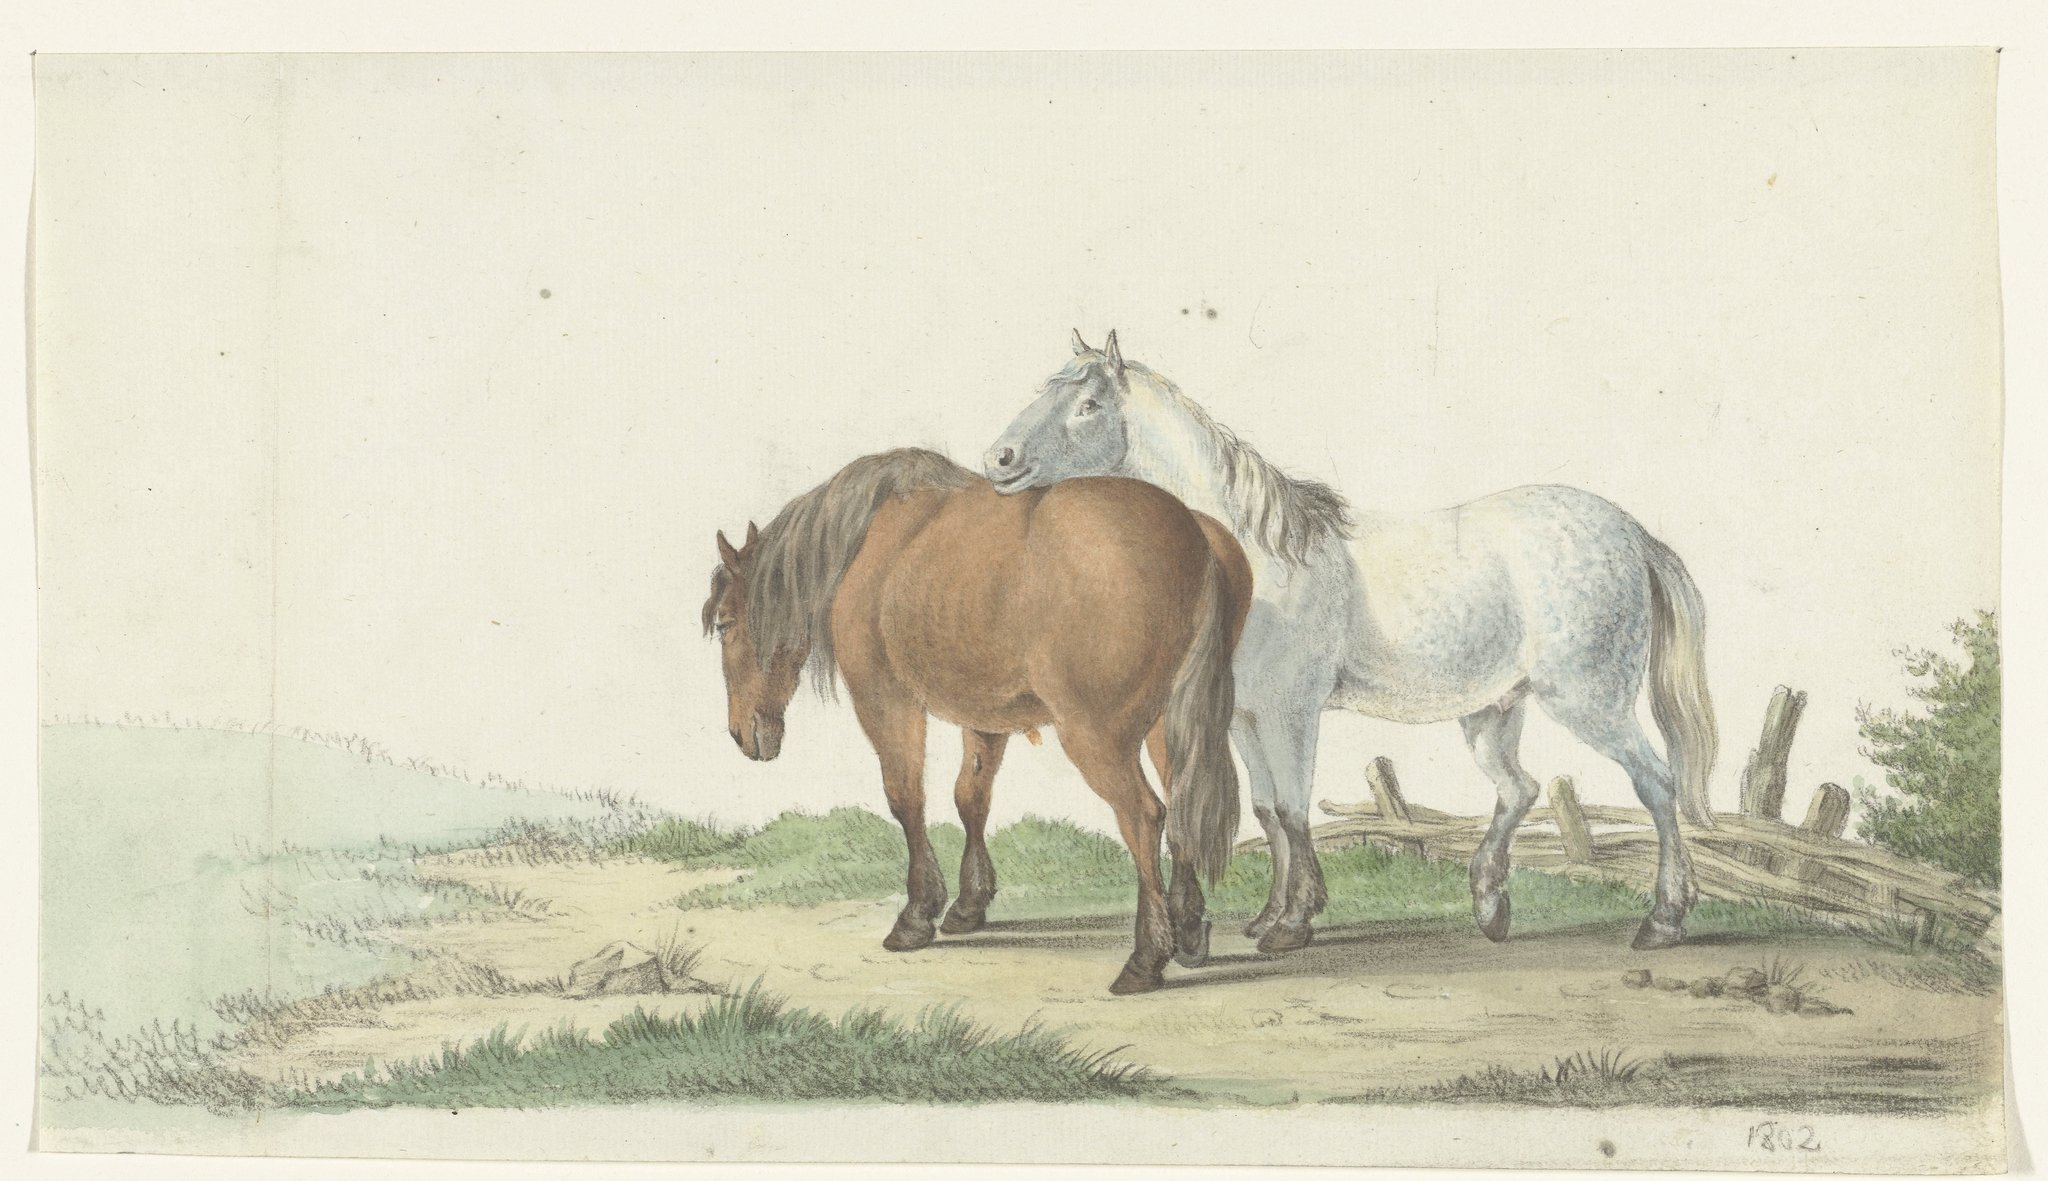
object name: watercolor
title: Een bruin en wit paard op een weg naast een hek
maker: jean bernard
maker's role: draughtsman, print maker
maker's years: 1765-1833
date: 1802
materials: paper, watercolor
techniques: brush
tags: horse